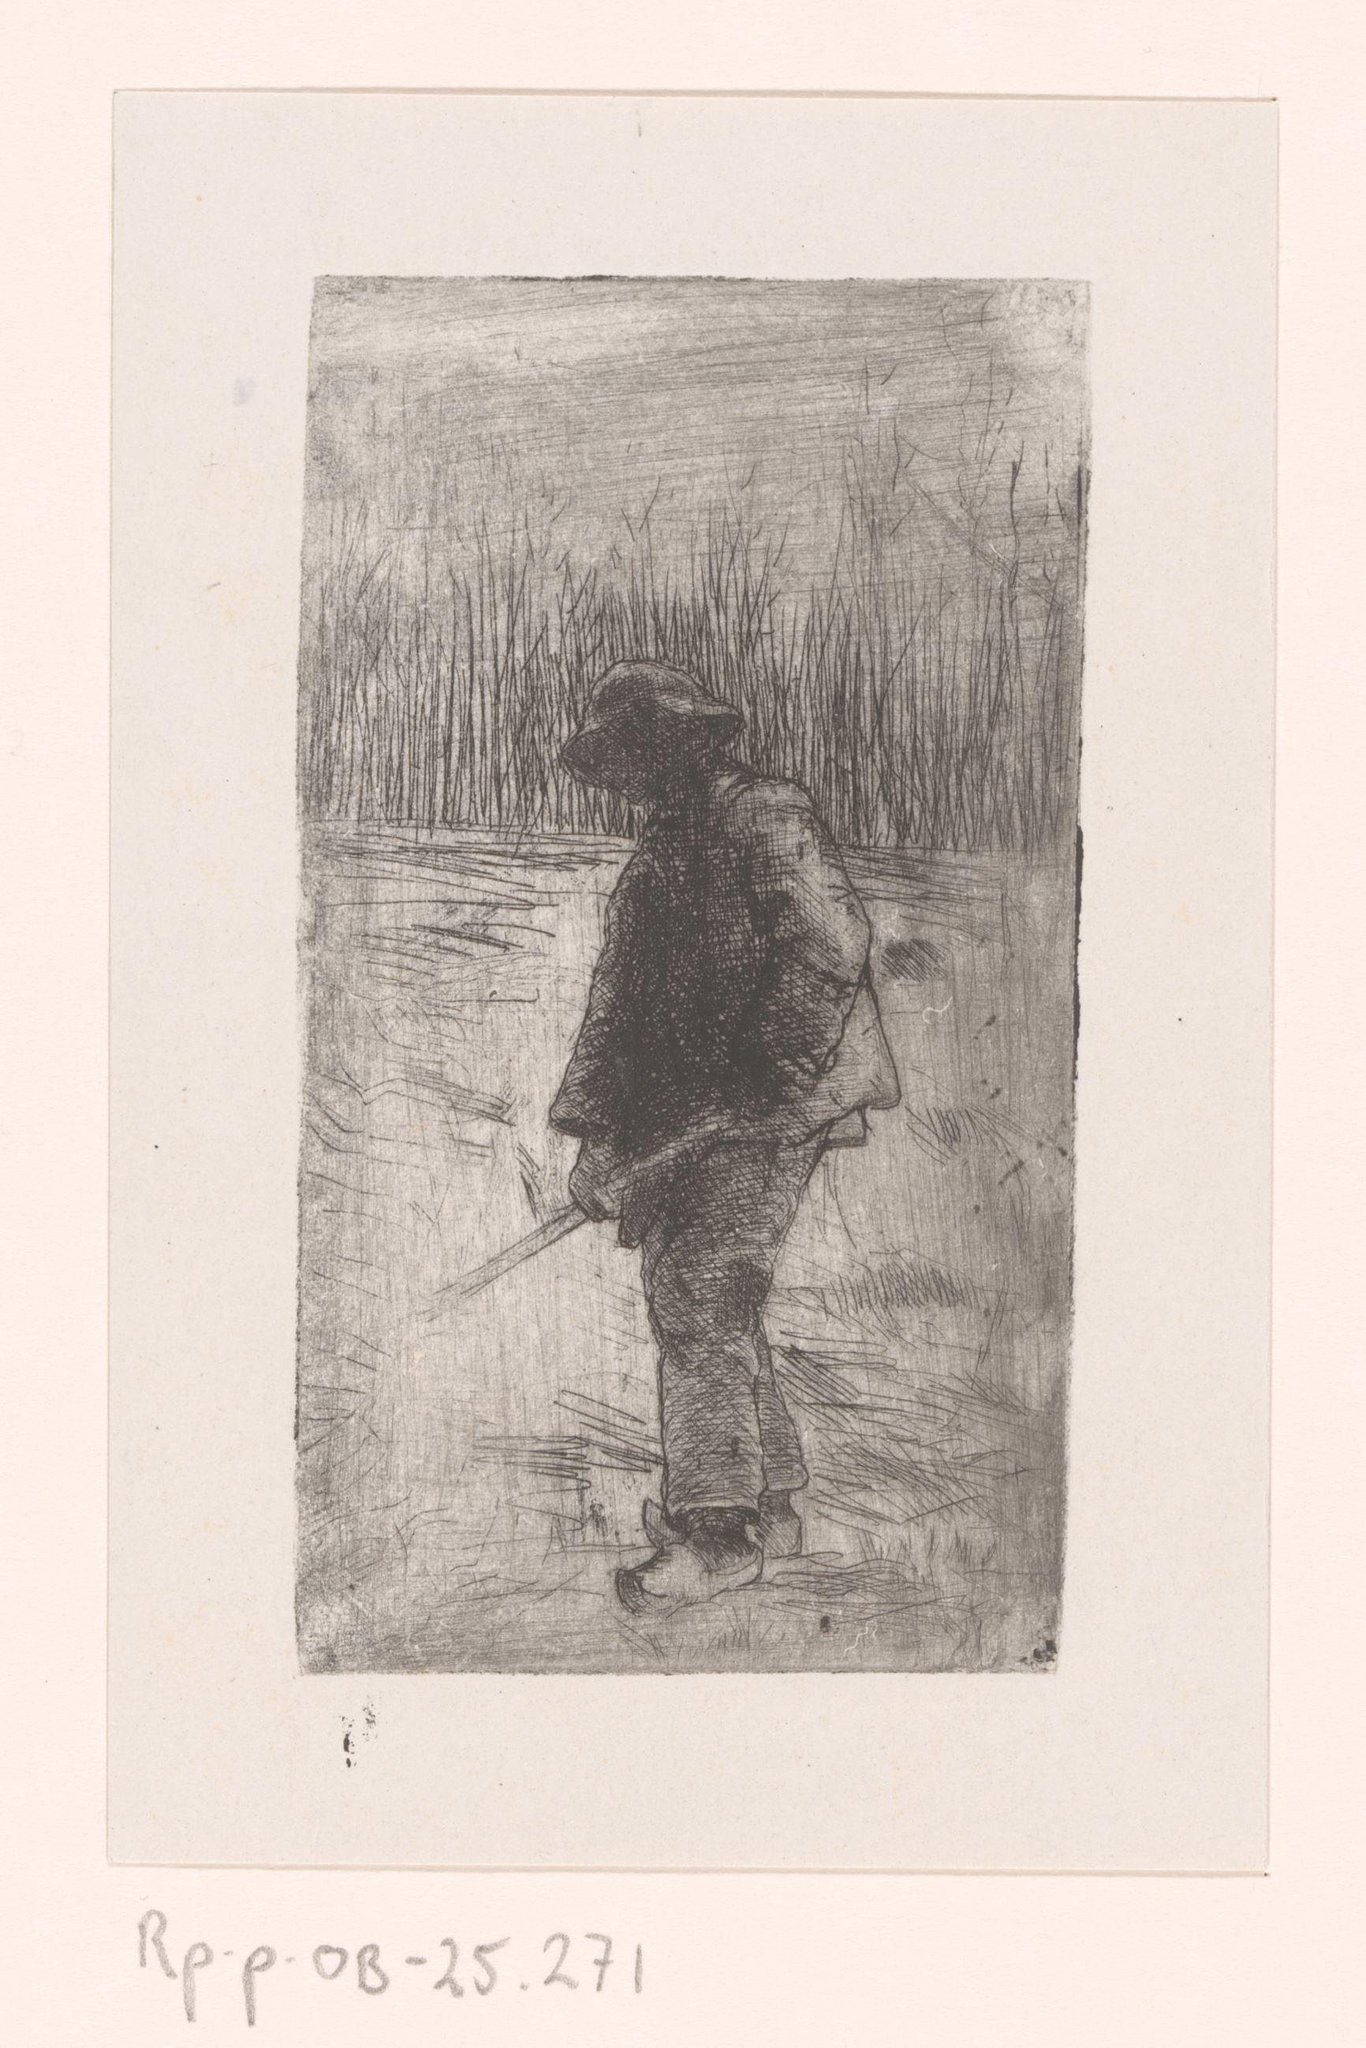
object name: print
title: Boer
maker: philip zilcken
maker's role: draughtsman, painter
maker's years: 1857-1930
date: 1867-1890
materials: paper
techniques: etching, intaglio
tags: farmers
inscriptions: collector's mark: Lugt 2228